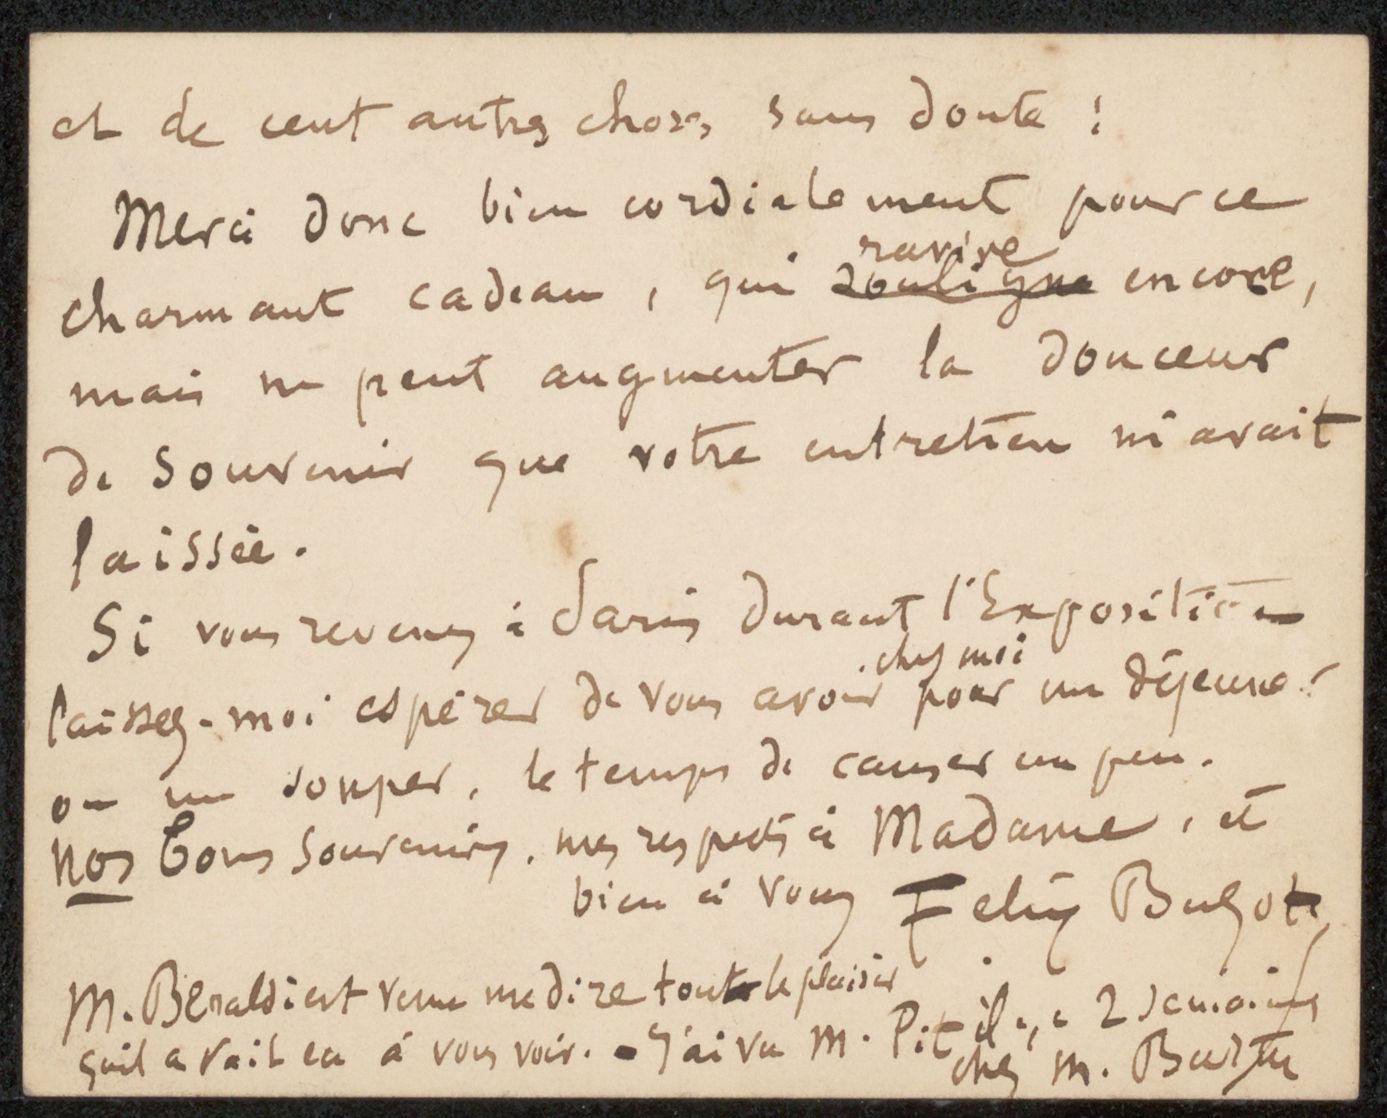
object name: letter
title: Brief aan Philip Zilcken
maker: félix hilaire buhot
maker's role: draughtsman, print maker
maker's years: 1847-1898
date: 1889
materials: cardboard, ink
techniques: pen, writing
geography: paris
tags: arnhem, painter, anton mauve, the hague, nijmegen, print maker, adriaan pit, philip zilcken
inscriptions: collector's mark: ‘RPK’, workshop stamp: ‘RPK’ Lugt 978